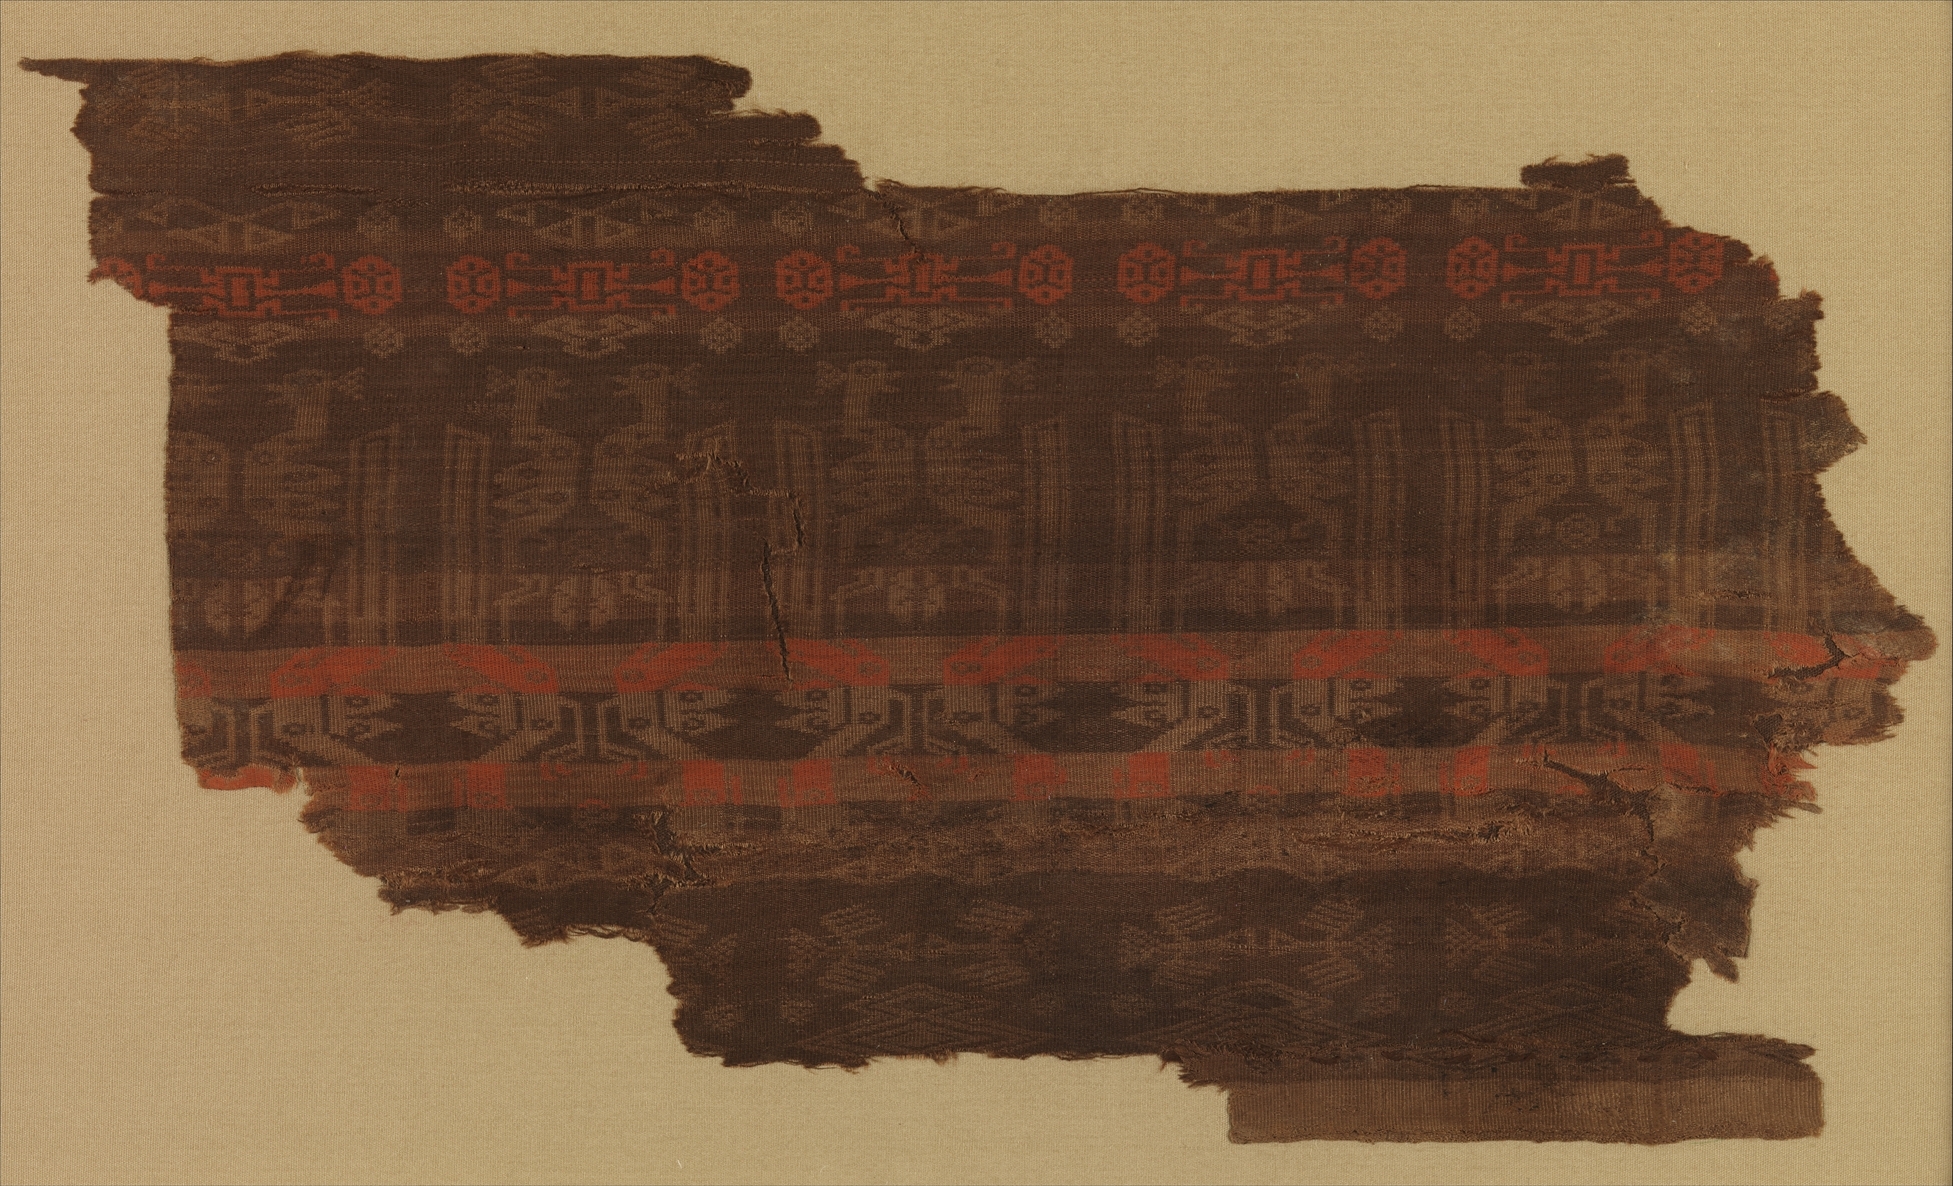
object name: fragment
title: Textile with Stripes and Confronted Birds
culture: chinese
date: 475-221 BCE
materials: silk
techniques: weave